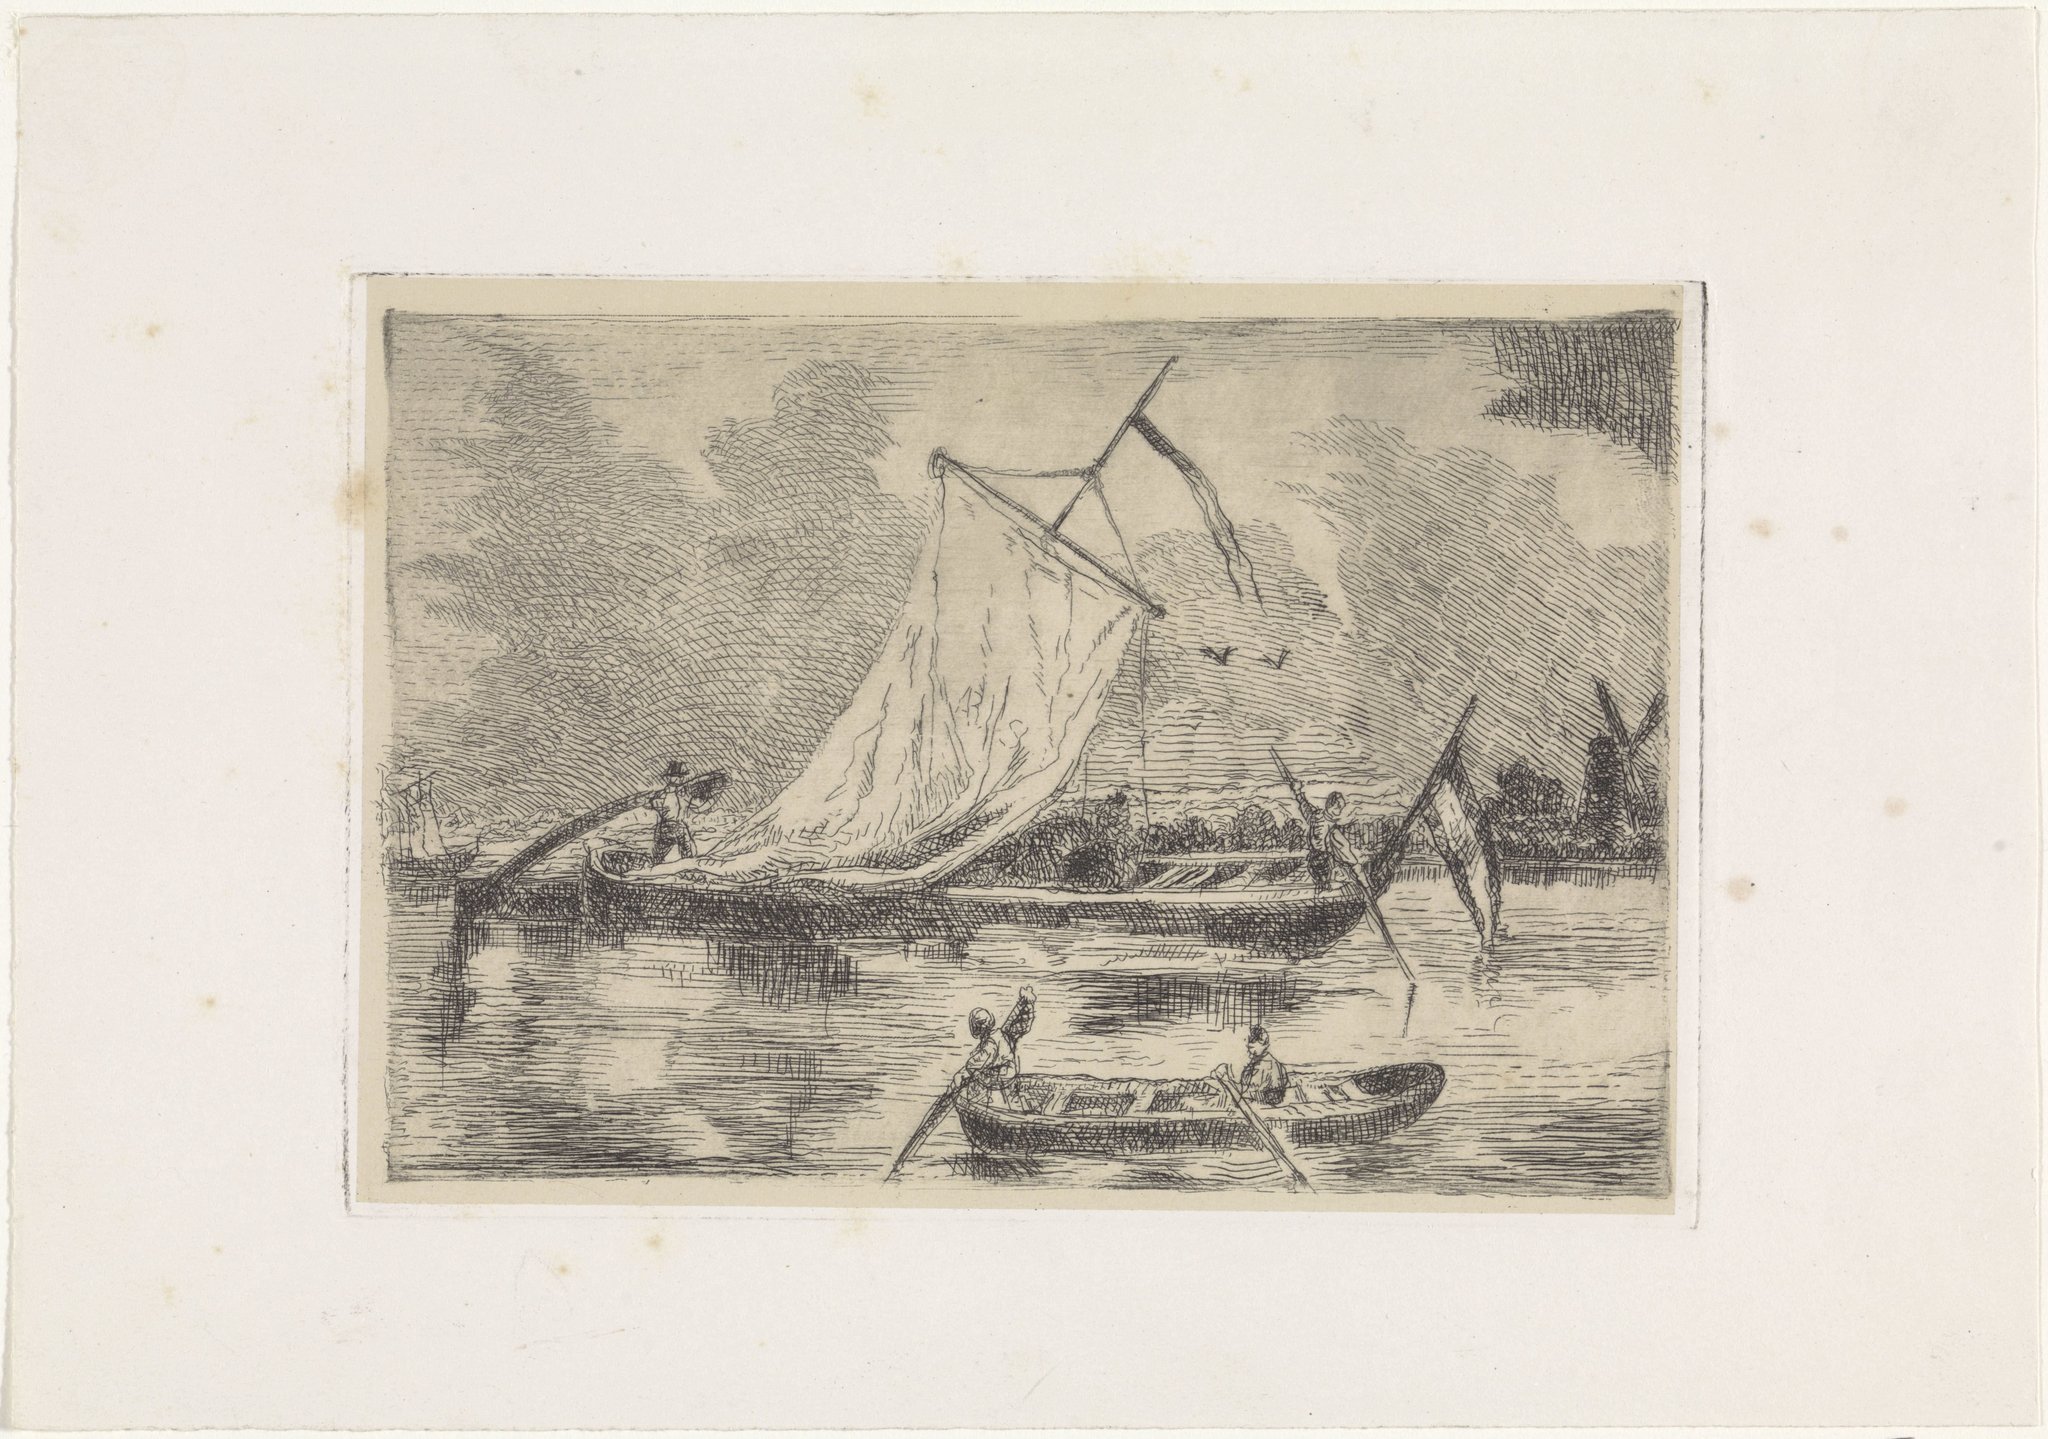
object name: print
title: Boten op het water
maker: arnoud schaepkens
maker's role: print maker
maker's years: 1816-1904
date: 1855-1904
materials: paper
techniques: etching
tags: landscapes with waters, waterscapes, seascapes (in the temperate zone), rowing-boat, canoe, etc.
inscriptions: collector's mark: Lugt 2228